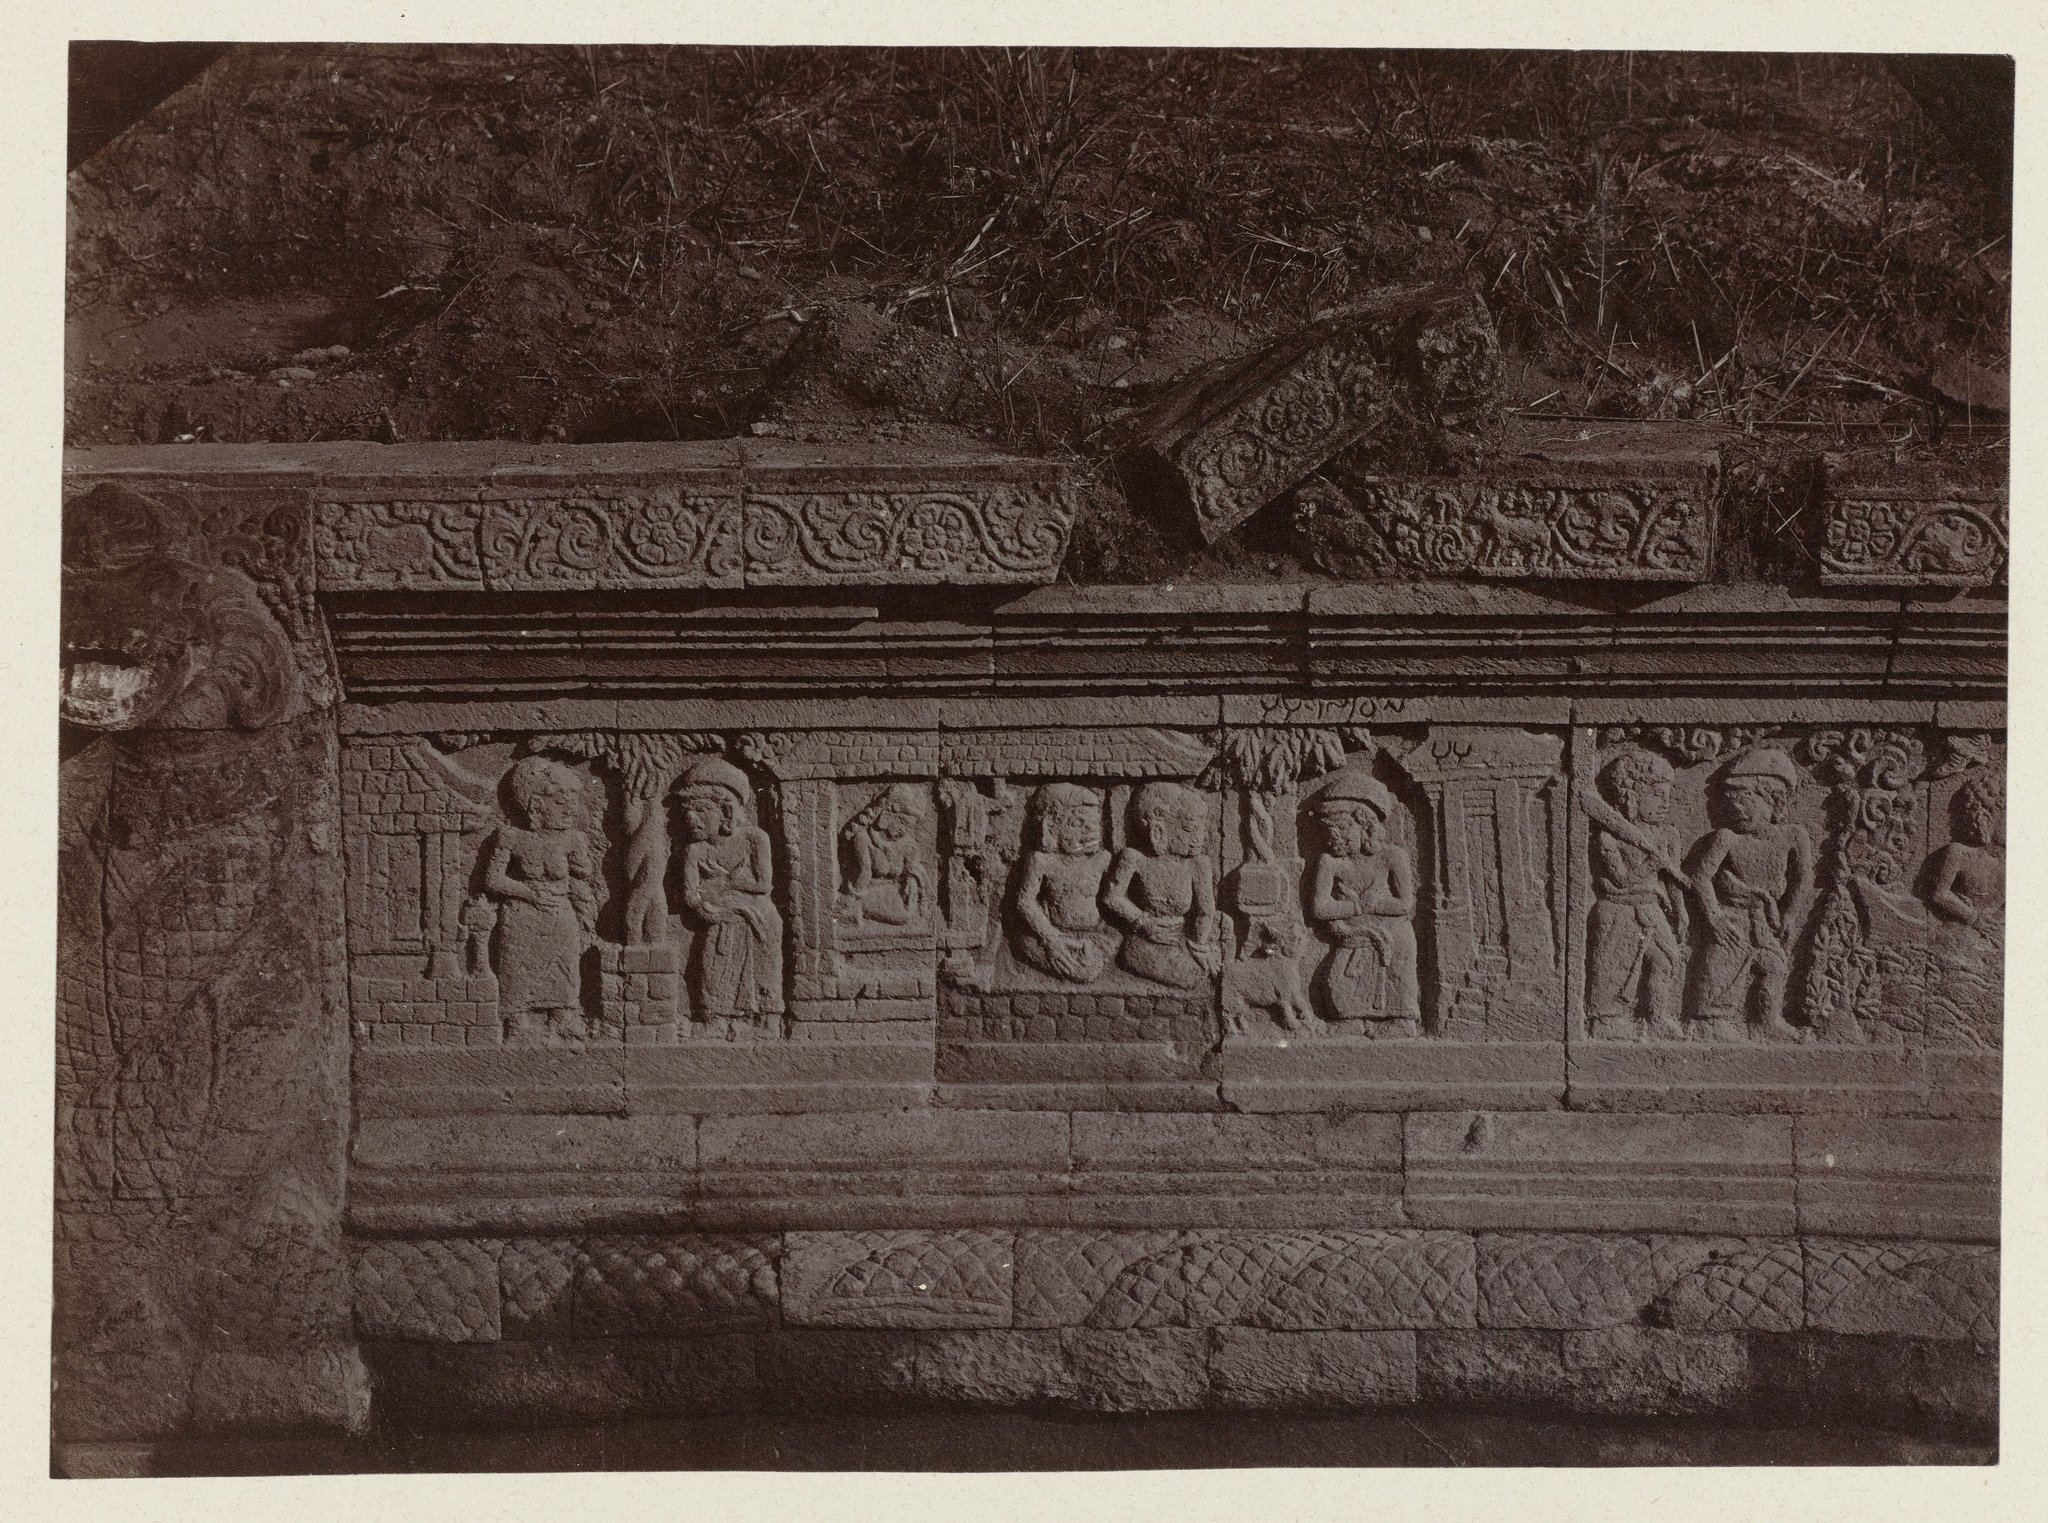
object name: photograph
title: Basrelief op het voetstuk eener pendopo (?) (oostzijde). Panataran (r. Kediri)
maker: isidore kinsbergen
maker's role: fotograaf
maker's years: 1821-1905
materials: cardboard, paper, photographic support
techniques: albumen print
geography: java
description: Candi Panataran (Temple Complex), Pendopo Terrace, unidentified reliefs 27-30 (inscription above no. 28 reads pupu sowasa, on the gate pupu), east side. Panataran, Blitar district, East Java province, 1375 AD